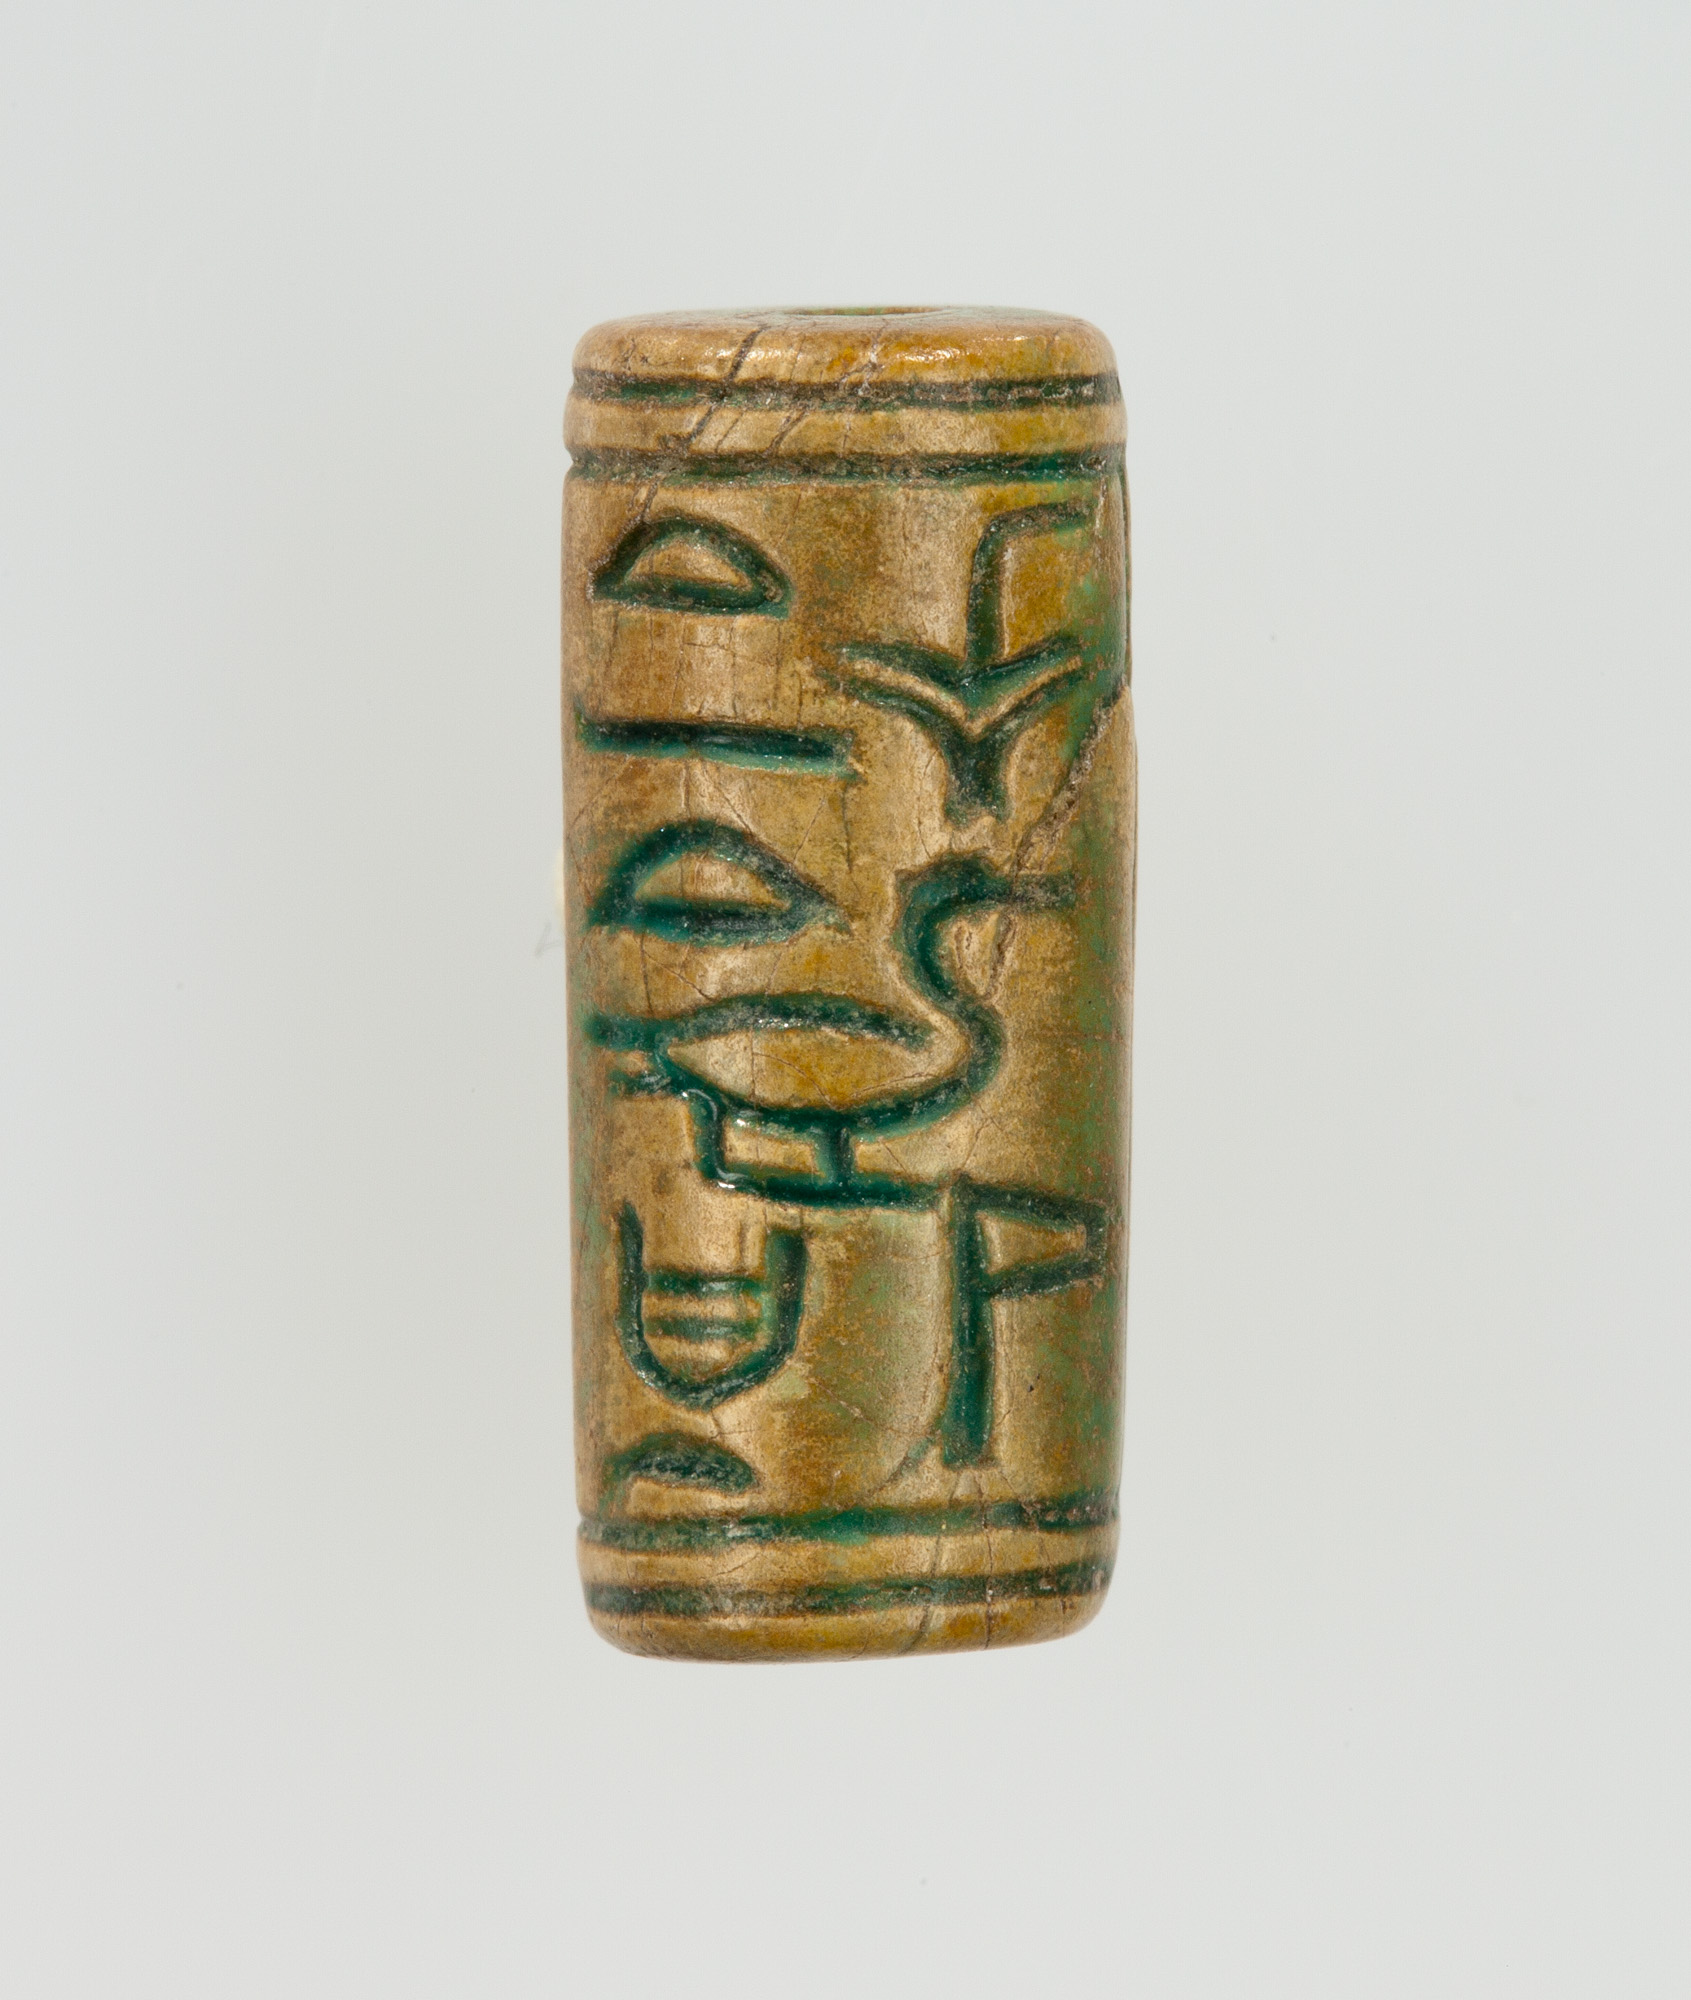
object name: cylinder seal, ahmose nefertari, god's wife, king's sister, king's daughter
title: Cylinder Bead Inscribed for (Ahmose-)Nefertari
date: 1550-1525 BCE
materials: stone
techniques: glazing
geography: egypt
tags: hieroglyphs